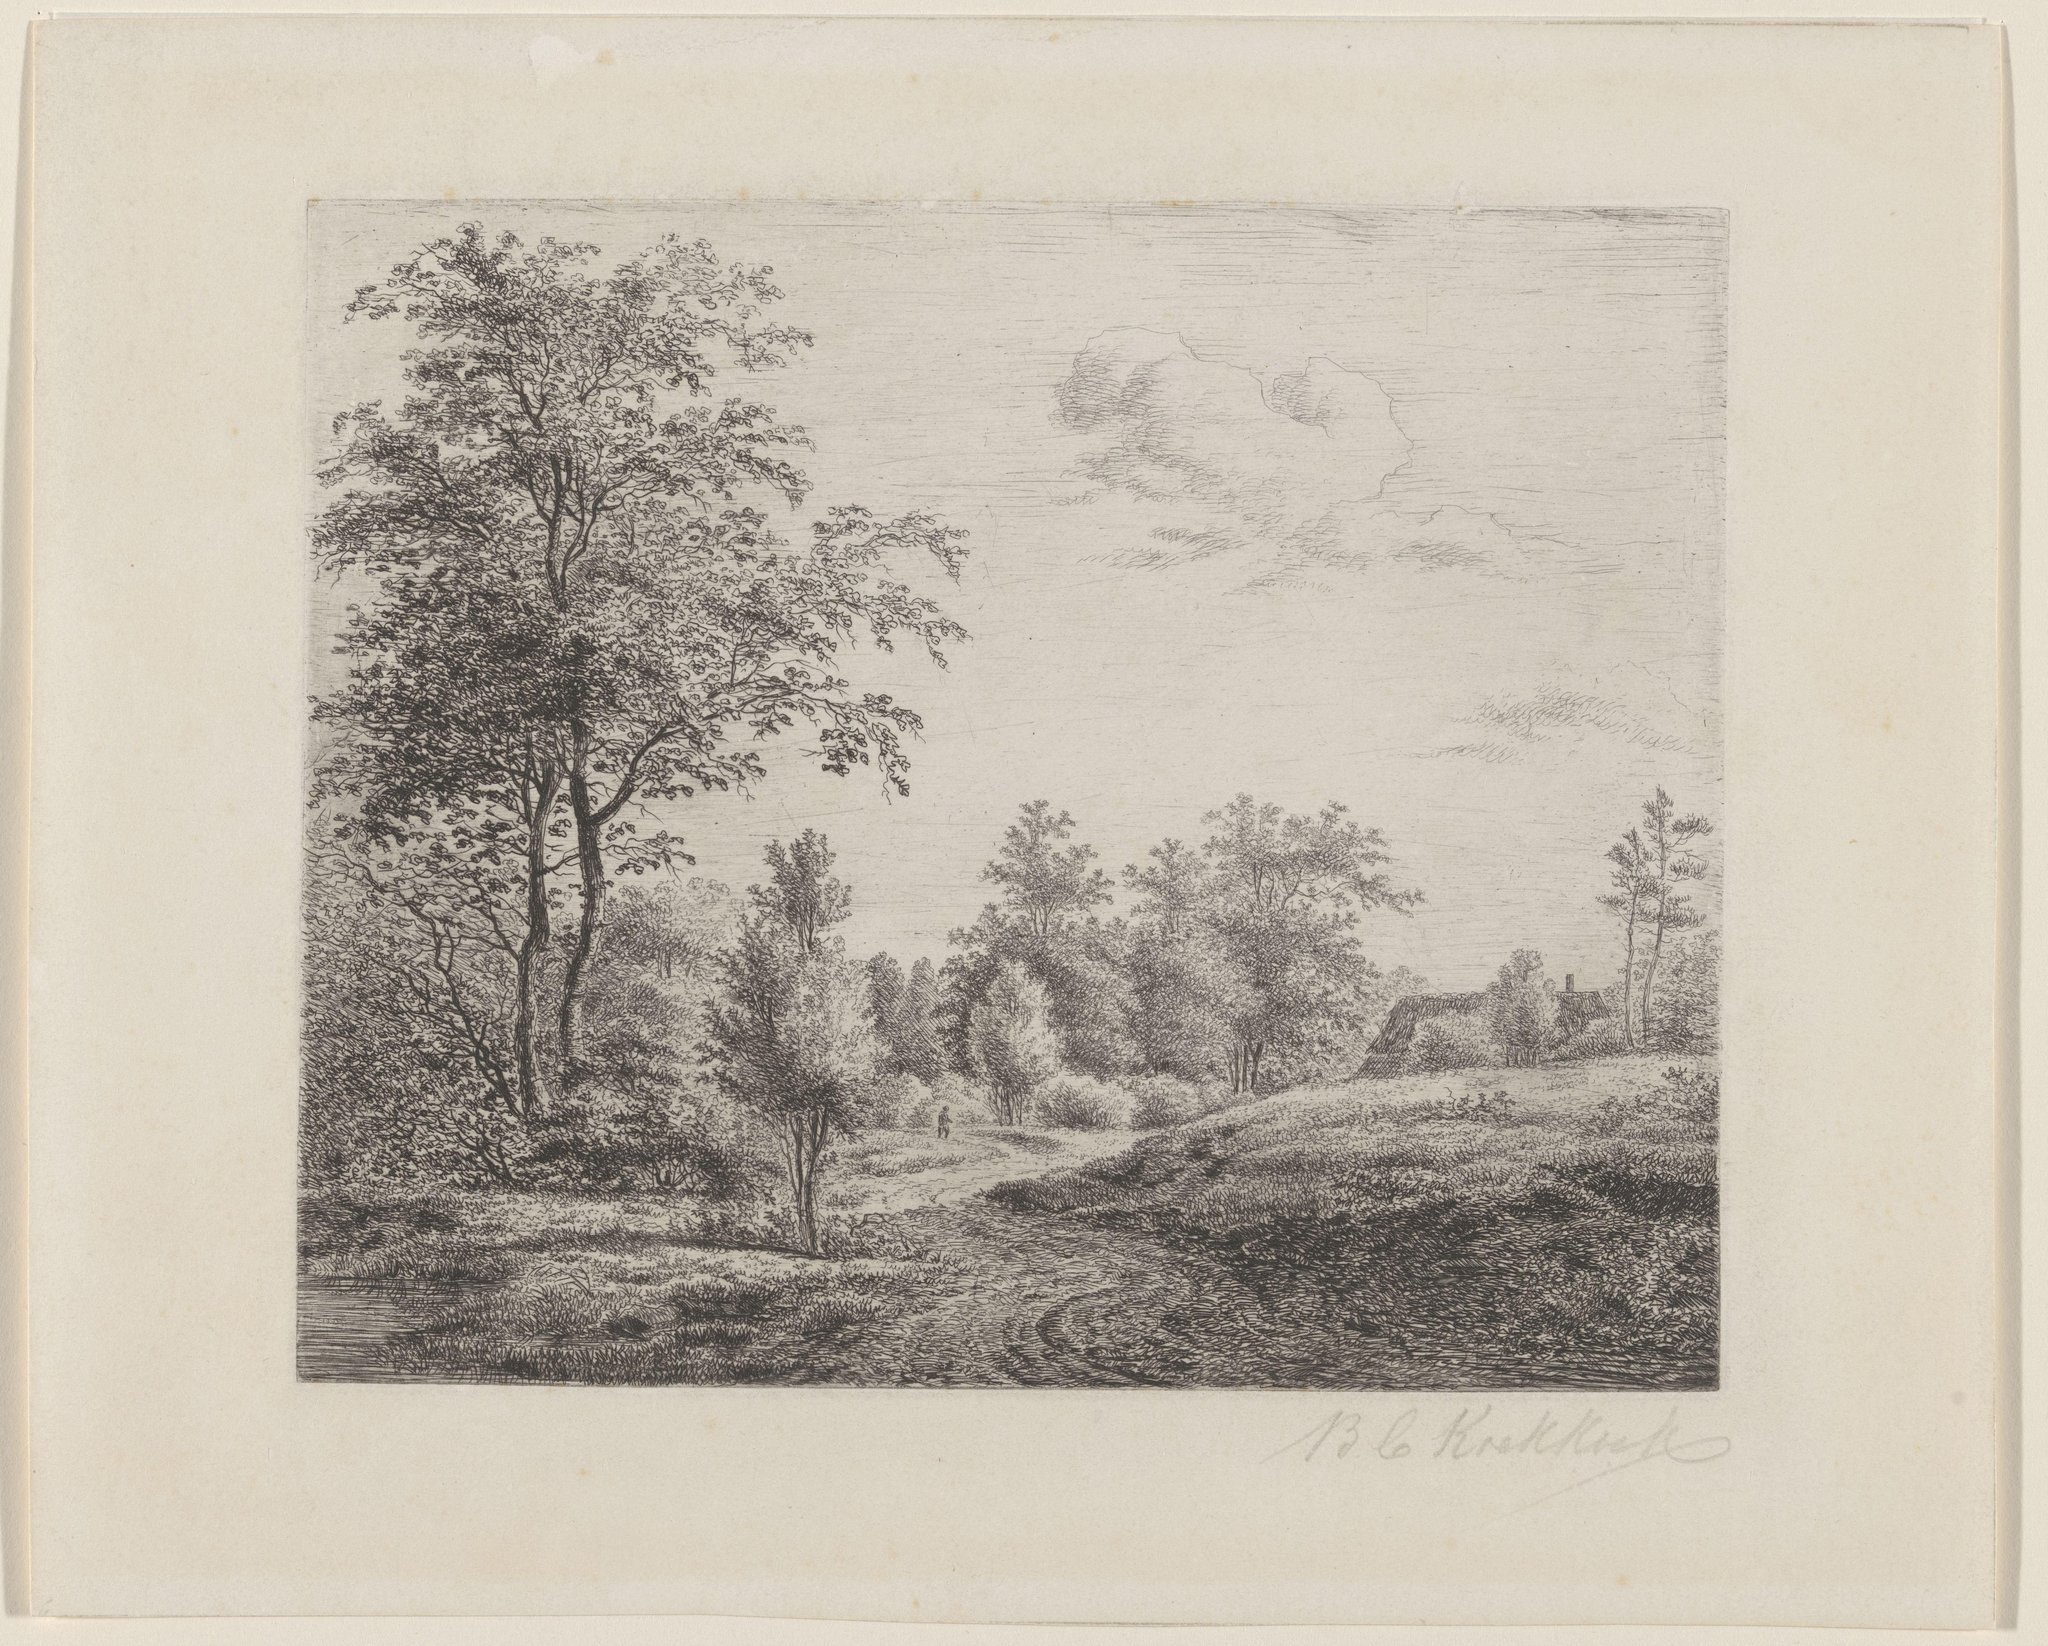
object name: print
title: Zomerlandschap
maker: barend cornelis koekkoek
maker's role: draughtsman, painter, print maker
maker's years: 1803-1862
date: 1820-1860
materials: paper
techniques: etching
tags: fringe, edge of the wood, forest path or lane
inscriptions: collector's mark: Lugt 2228, collector's mark: Lugt 2760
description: Zomerlandschap. Wandelaar op een pad langs de rand van een bos, rechts het dak van een huis.